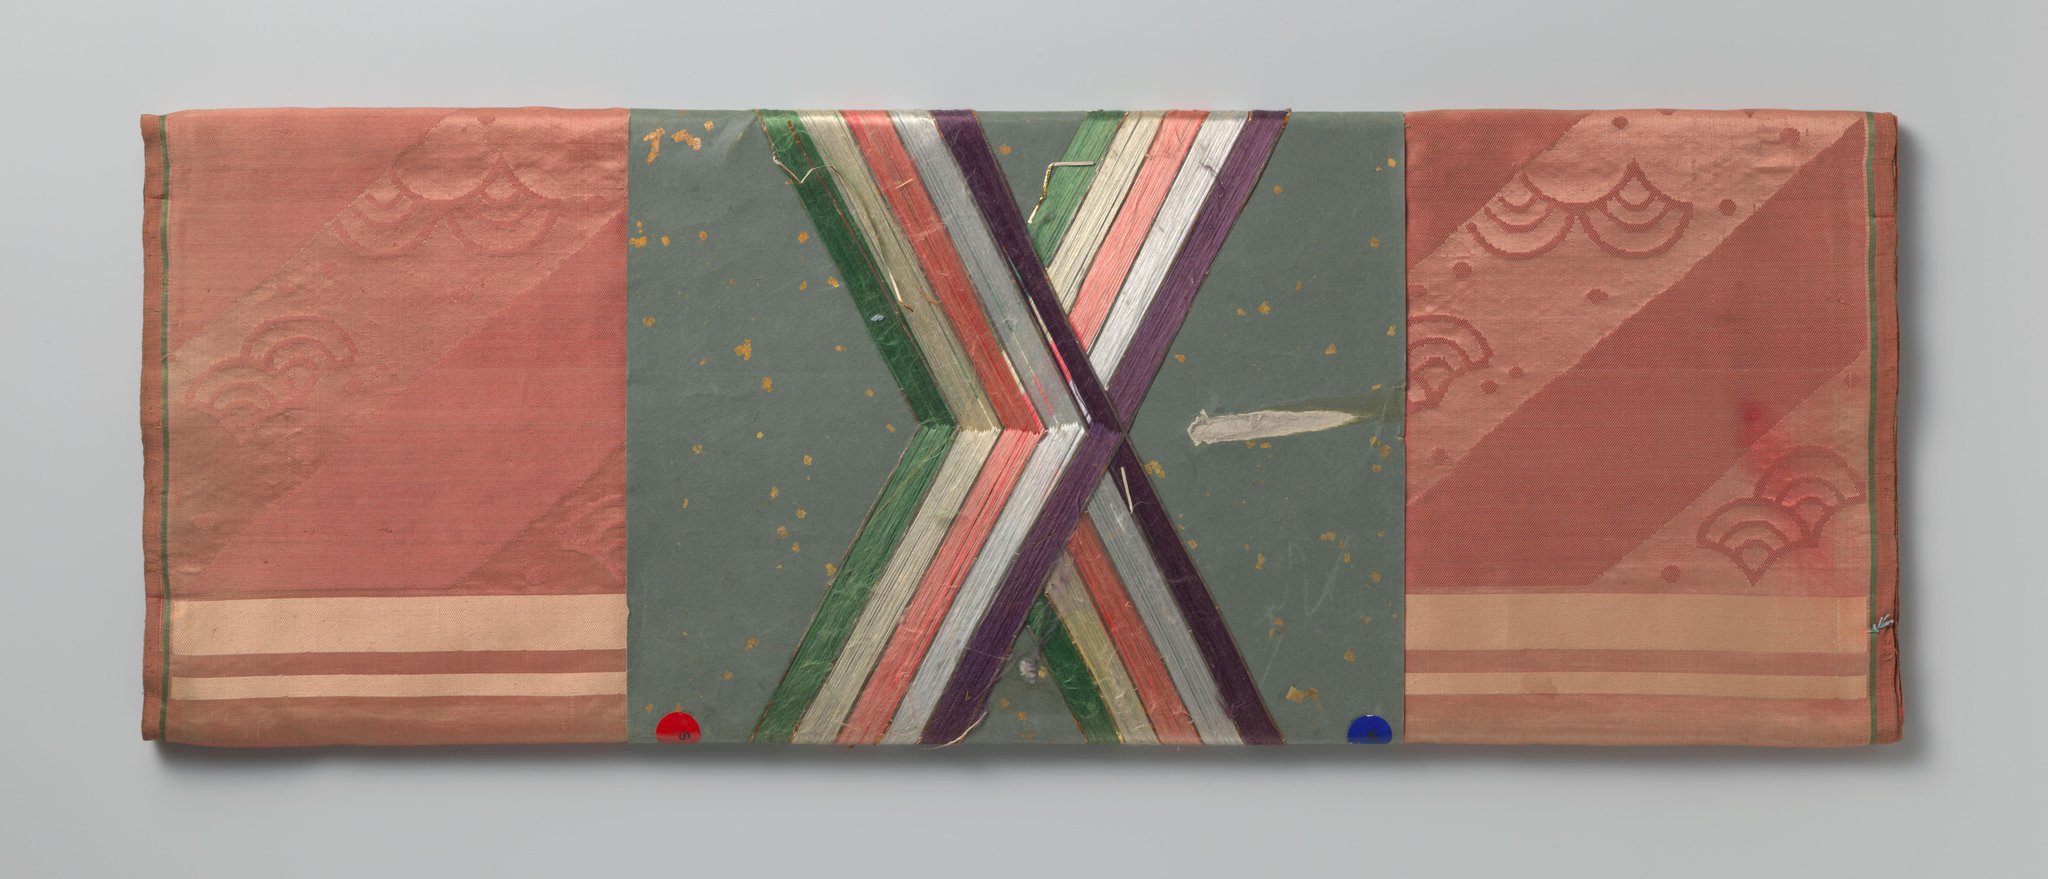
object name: silk textile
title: Plank van papier waarop zijdeweefsel met dessin van diagonale banen, versierd met een zich herhalend patroon van telkens twee waaiervormen en stippen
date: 1900-1920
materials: paper, silk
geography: japan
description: Plank van papier waarop zijdeweefsel met dessin van diagonale banen, versierd met een zich herhalend patroon van telkens twee waaiervormen en stippen. De zogenaamde plank van papier, heeft tien strengen floszijde en verzilverd papieren lamel. Het papier is hardgeschept en is écru van kleur. Opmerking: dit is de originele verpakking van de zijde. Oosters textiel.